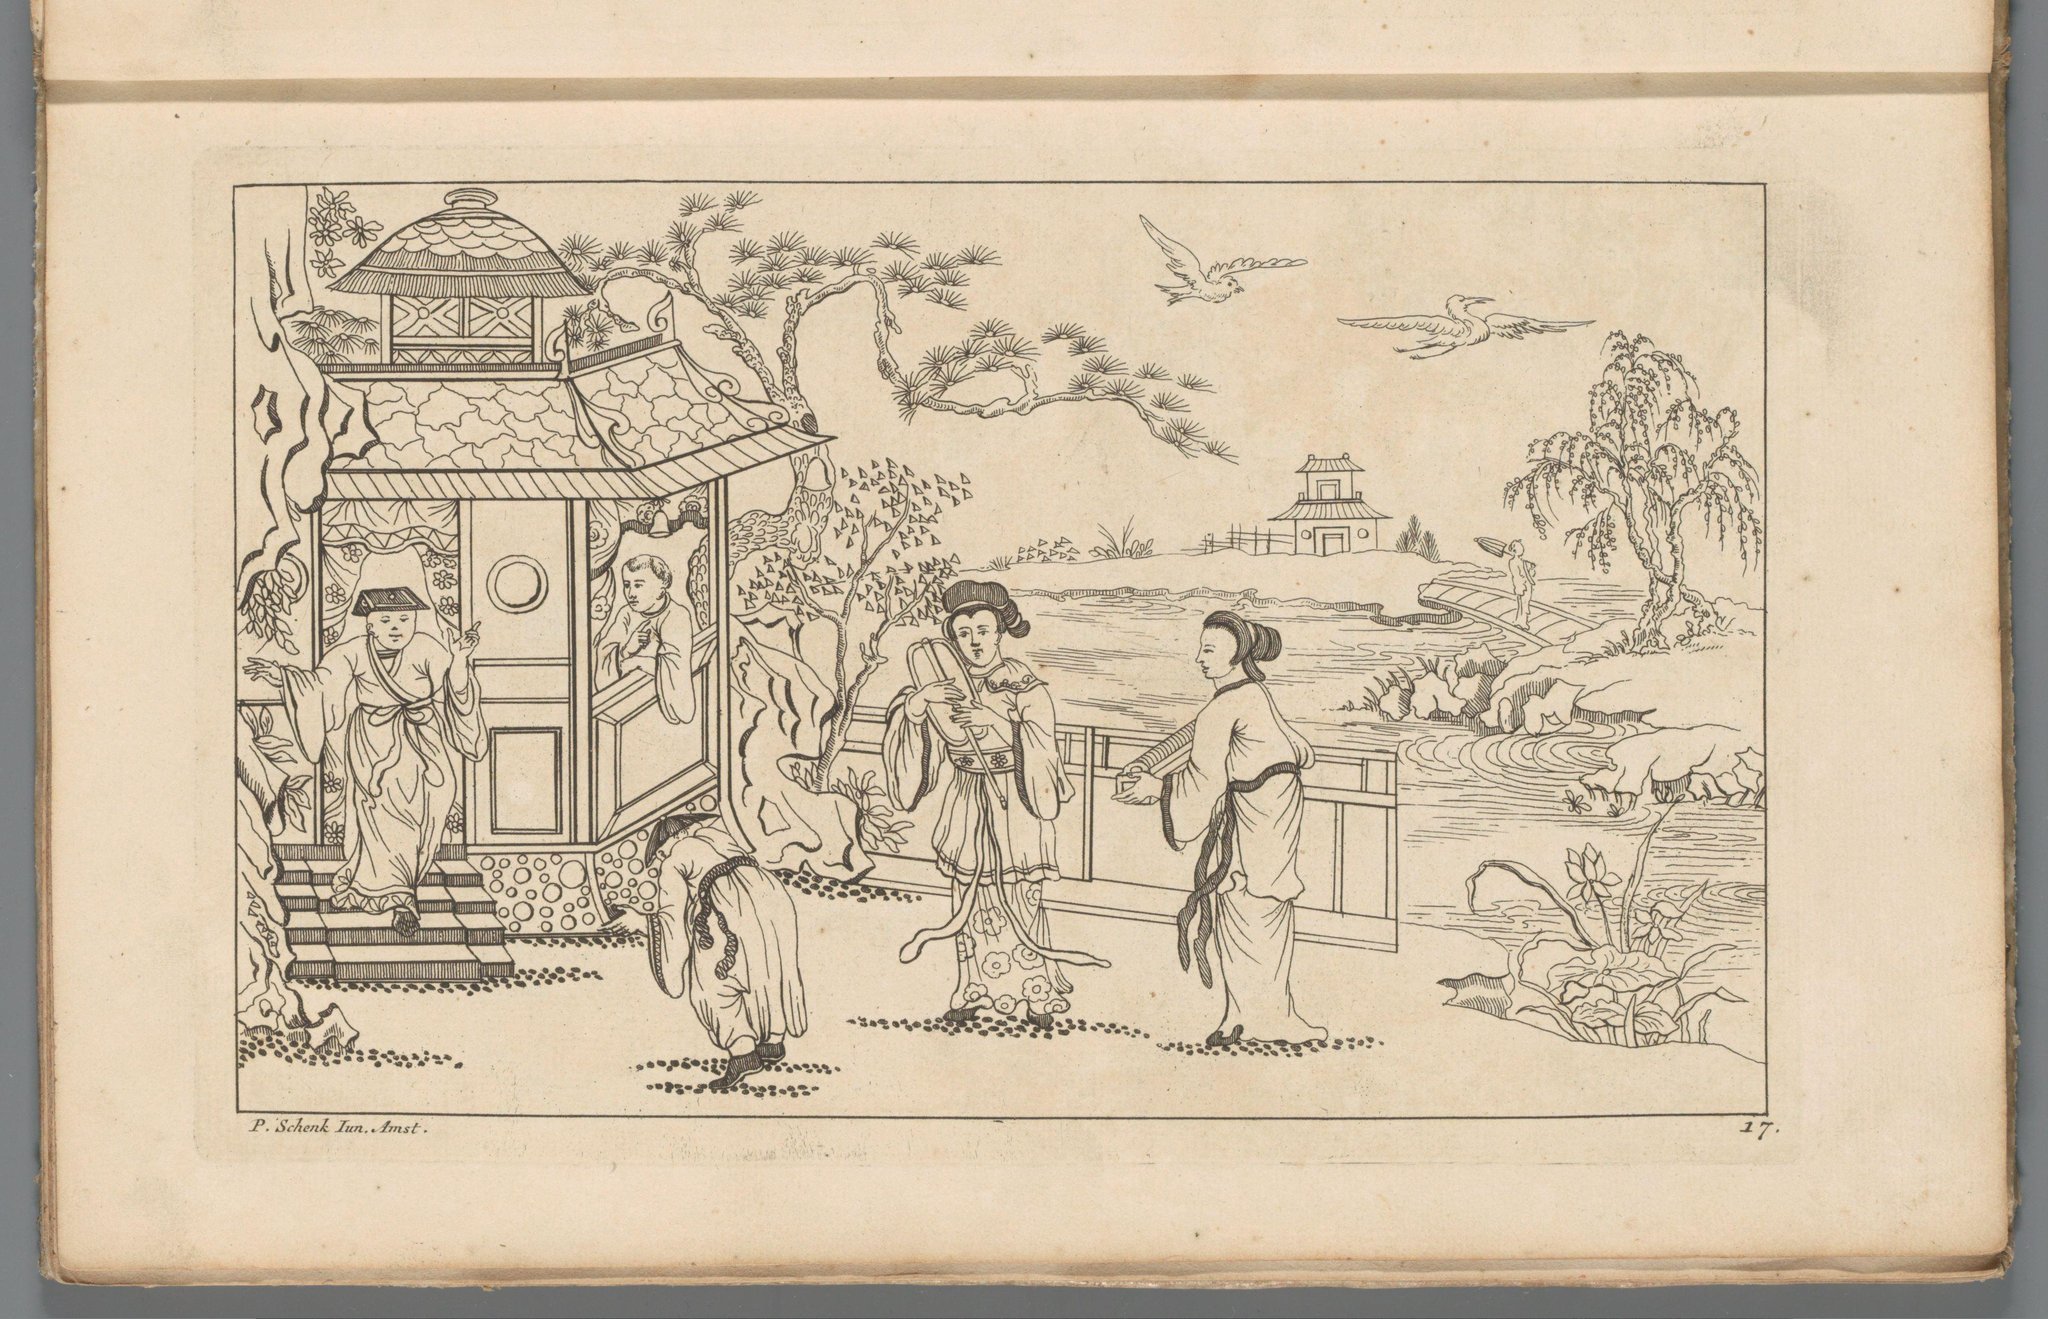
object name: album leaf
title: Chinese landscape with figures and a pavilion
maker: pieter schenk (ii)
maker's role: draughtsman, print maker, publisher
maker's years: 1693-1775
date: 1715-1725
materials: paper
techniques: etching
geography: amsterdam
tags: chinese, landscapes in the temperate zone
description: This album contains 84 etchings: with only two exceptions, all the chinoiserie prints that are currently known by father and son Schenk. The prints were made in a pseudo-Chinese style that was then unknown in Northern Europe: their paintbrush-like lines and flattened perspective hark back to Chinese woodcuts and paintings.